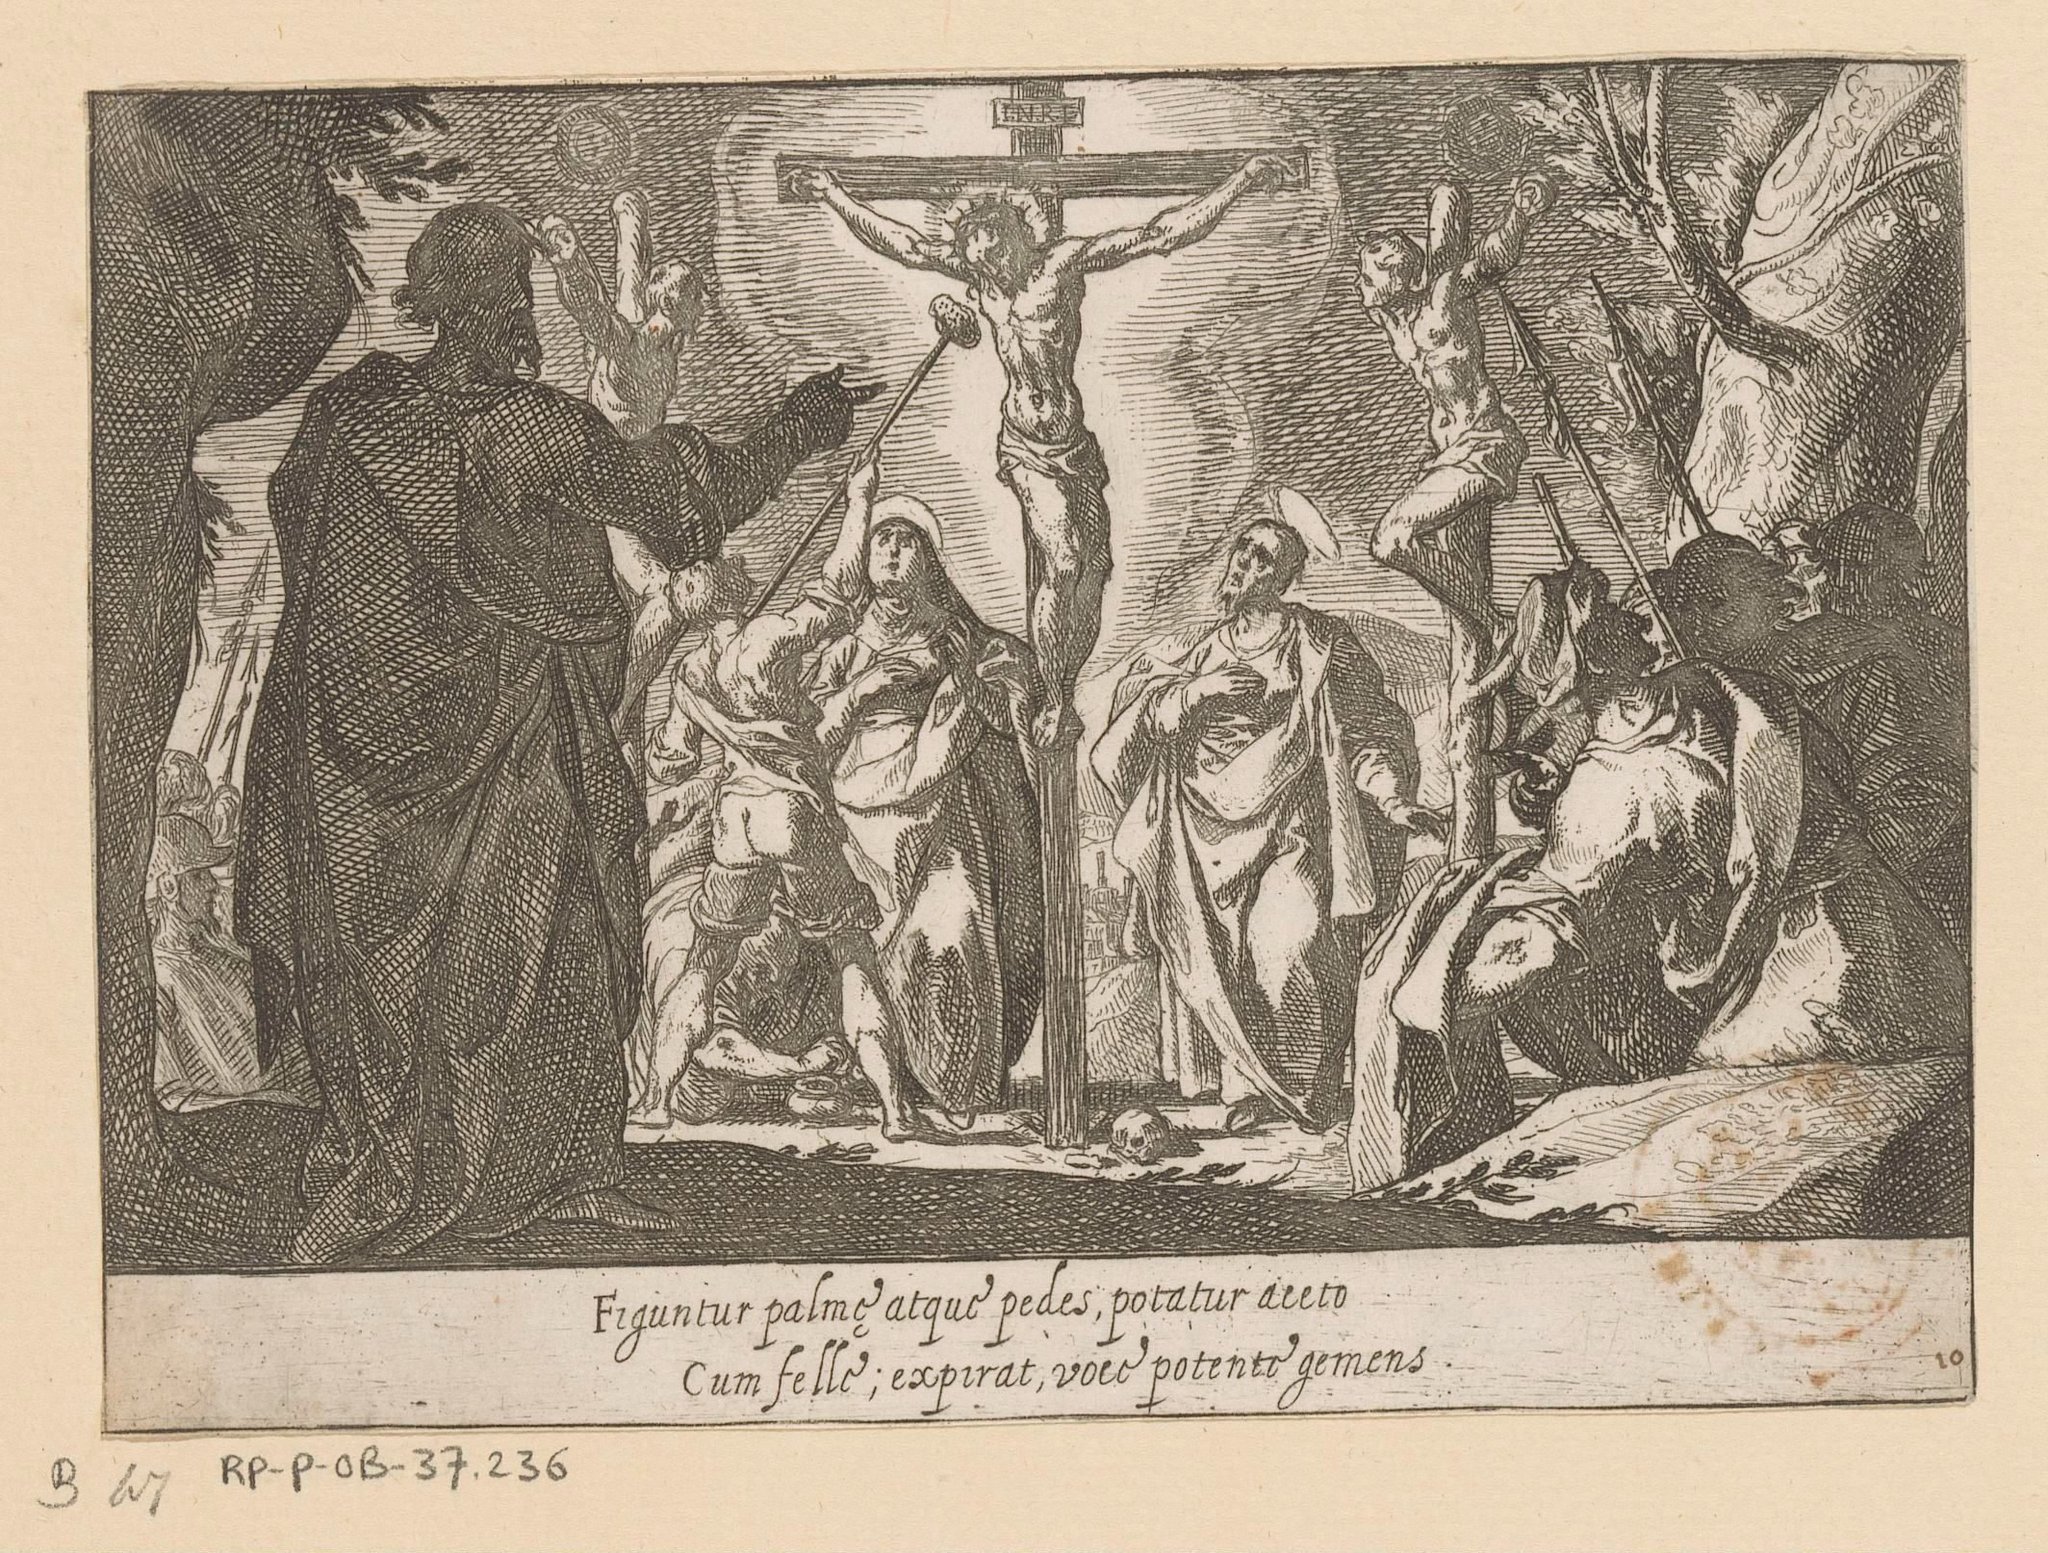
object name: print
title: Vijftien Mysteries van de Rozenkrans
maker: raffaello schiaminossi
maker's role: painter, print maker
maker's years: 1572-1622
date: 1602-1604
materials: paper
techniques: etching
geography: rome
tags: the crucifixion of christ: christ's death on the cross; golgotha (matthew 27:45-58; mark 15:33-45; luke 23:44-52; john 19:25-38)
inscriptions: number: ‘10’, collector's mark: Lugt 240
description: De prent maakt deel uit van de serie 'Quindecim Mysteria Rosarii Beatae Mariae Virginis'. De serie bestaat uit een titelprent en vijftien prenten met voorstellingen van de Mysteries van de Rozenkrans (episodes uit de levens van Christus en Maria). In een andere staat is de prent in de plaat genummerd linksonder: 10.